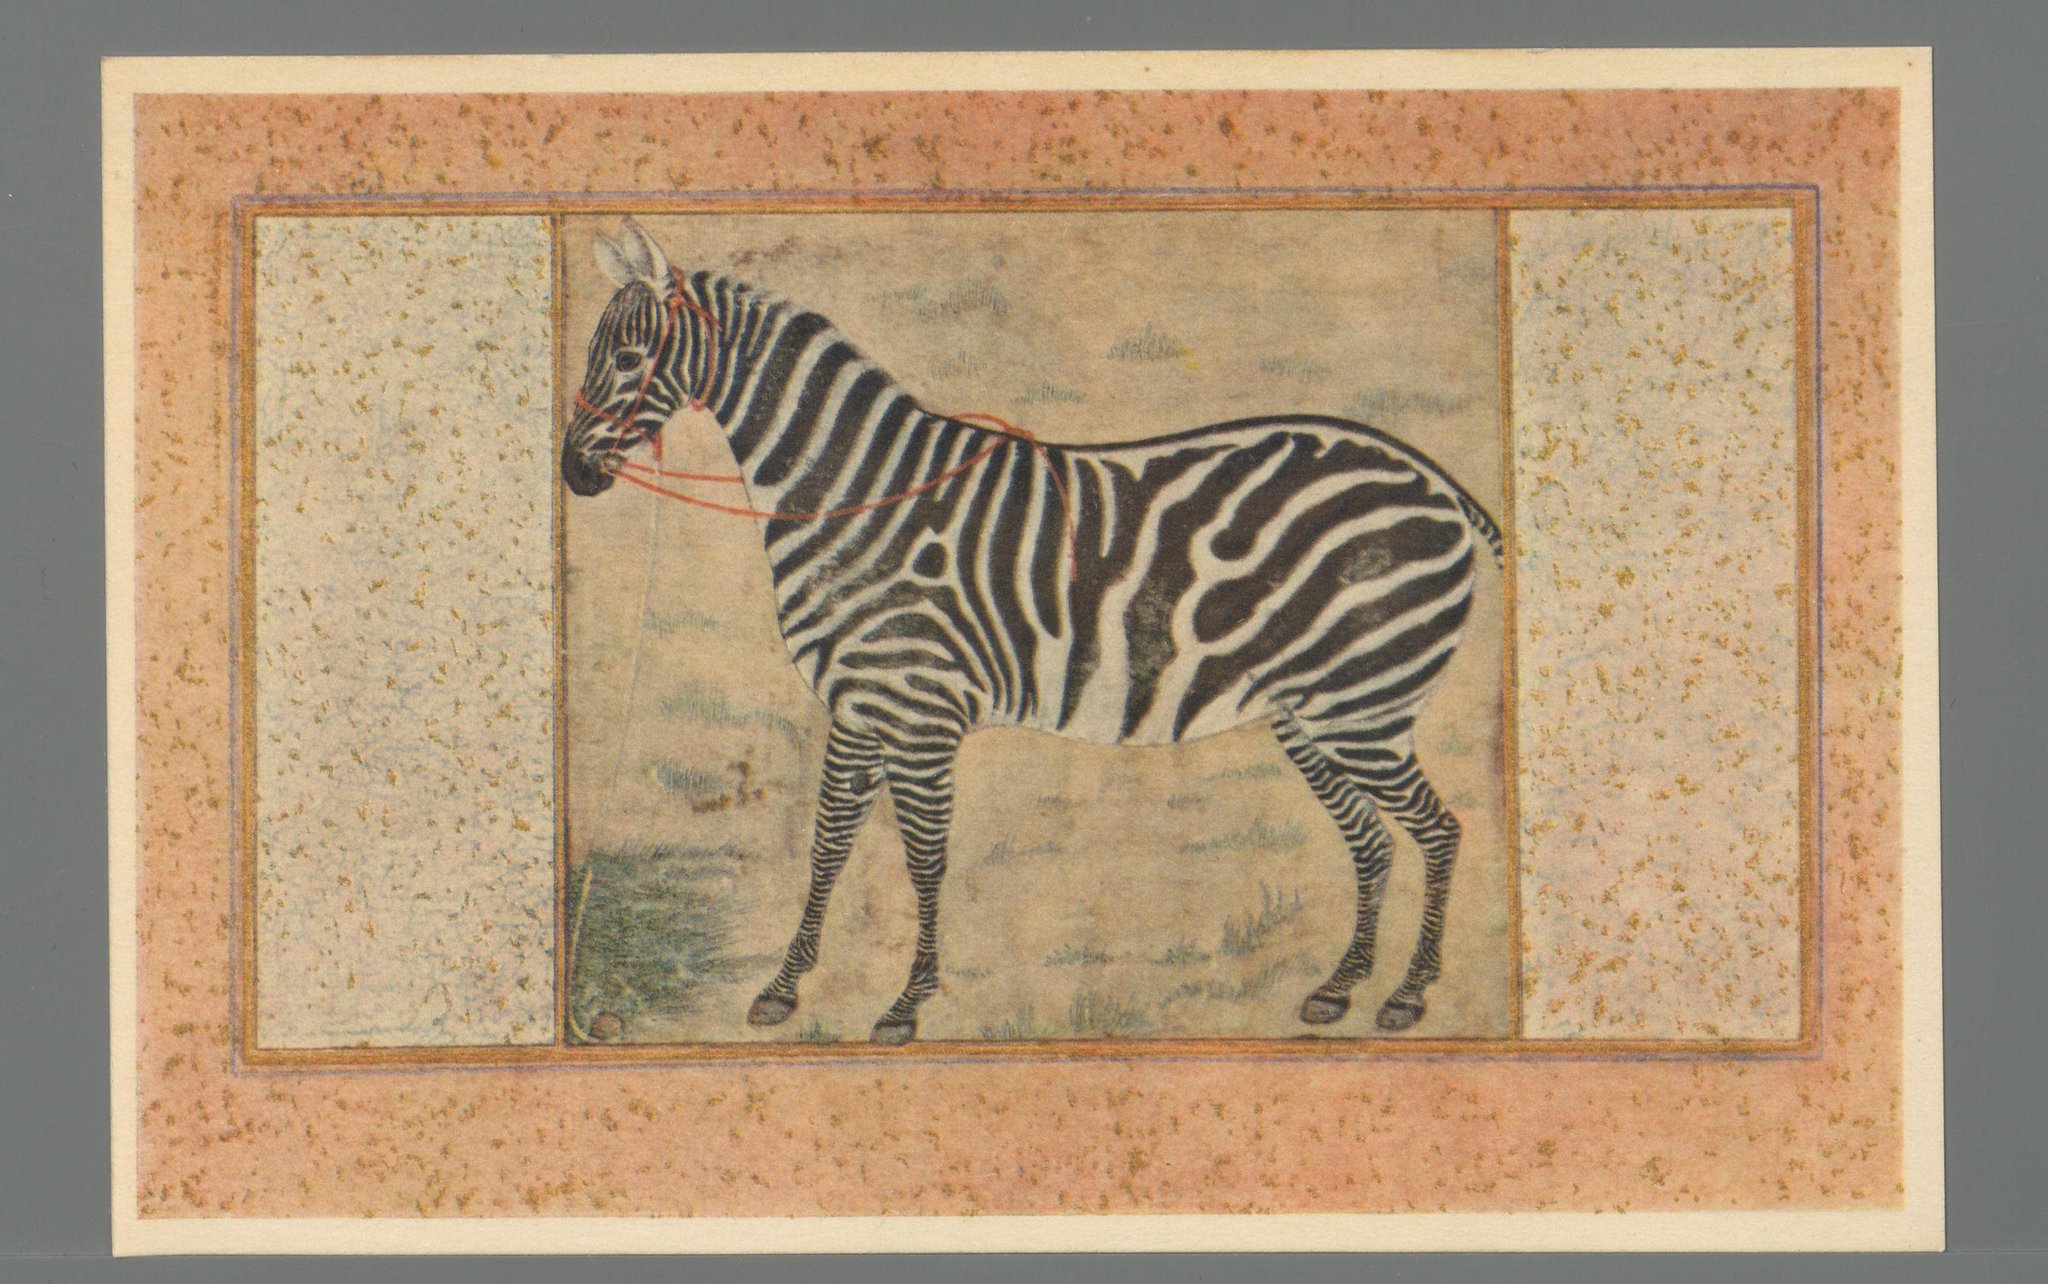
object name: reproduction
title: Zebra. Attributed to Ustad Mansur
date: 1914-1940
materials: cardboard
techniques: photograph, lithograph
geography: boston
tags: hoofed animals (with name)